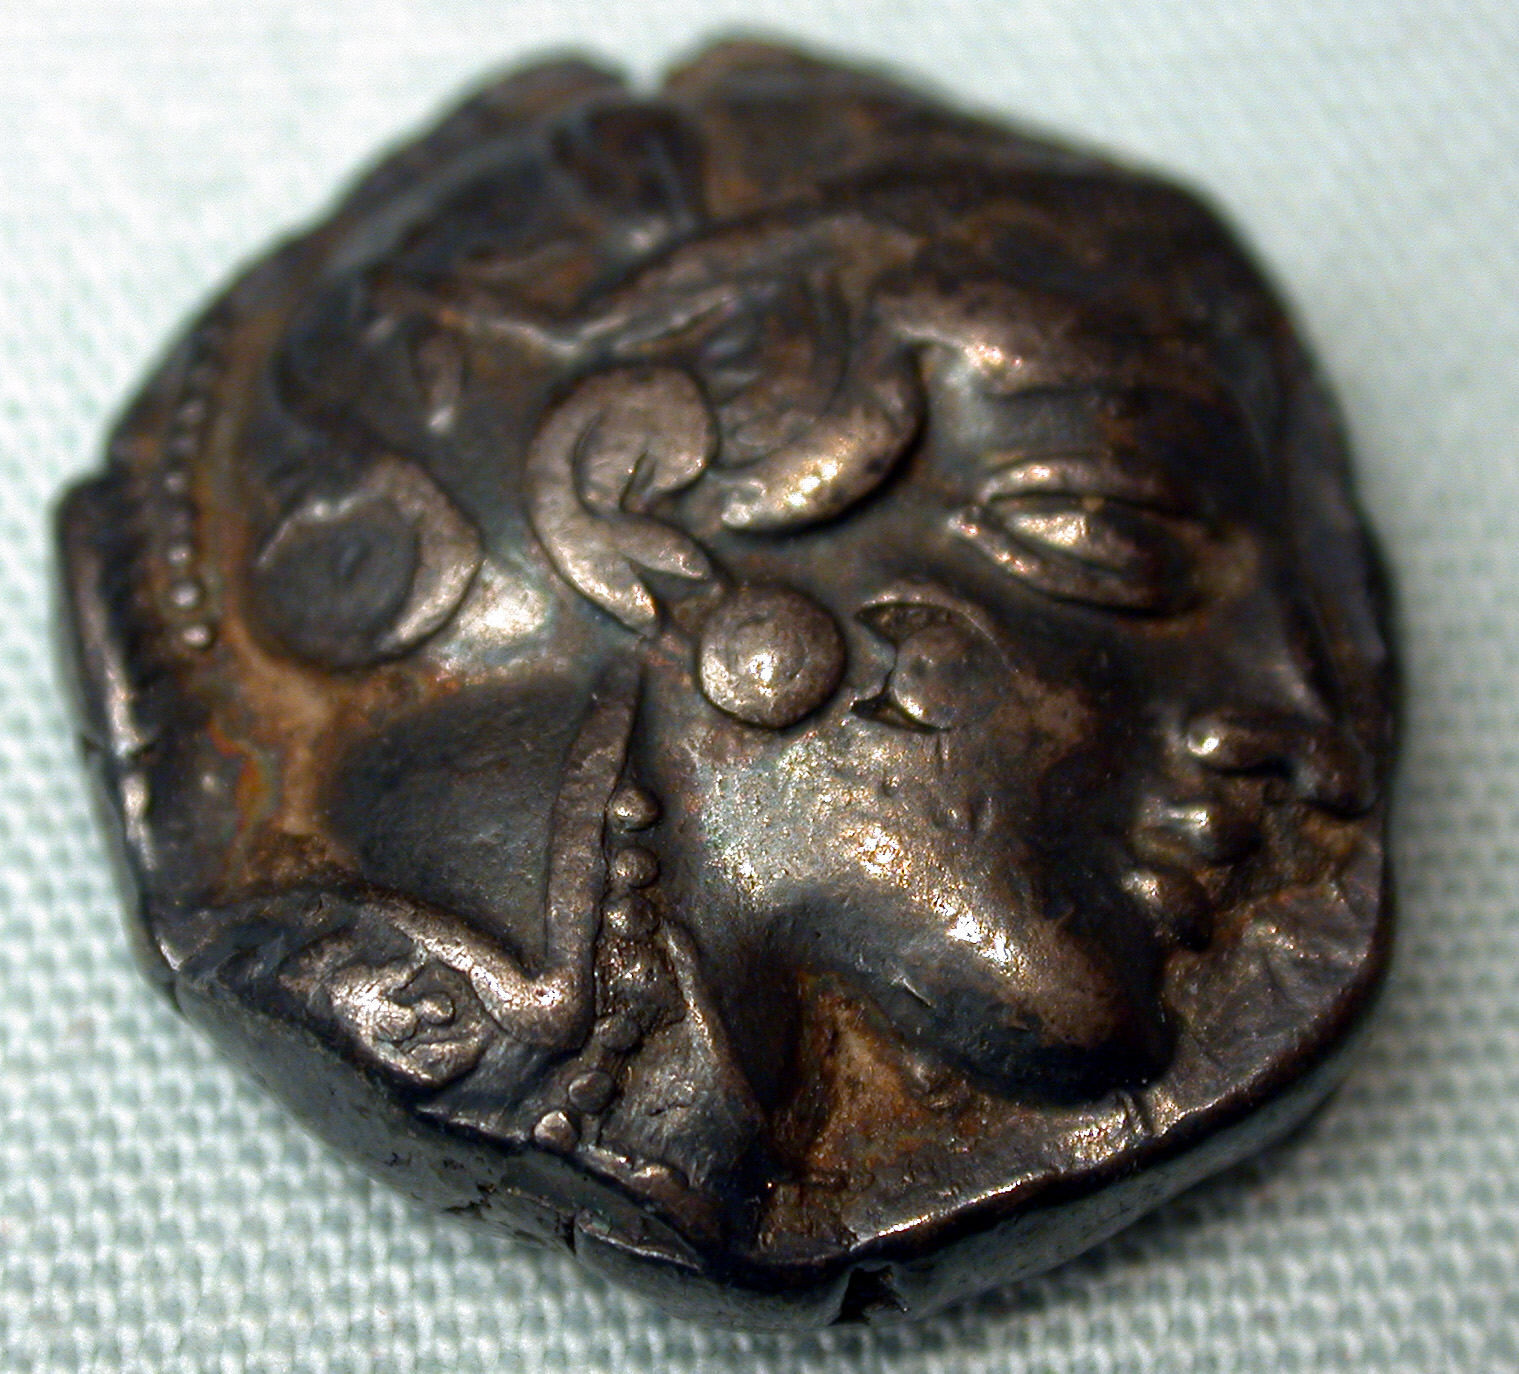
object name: tetradrachm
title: Silver tetradrachm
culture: greek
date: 440-404 BCE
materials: silver